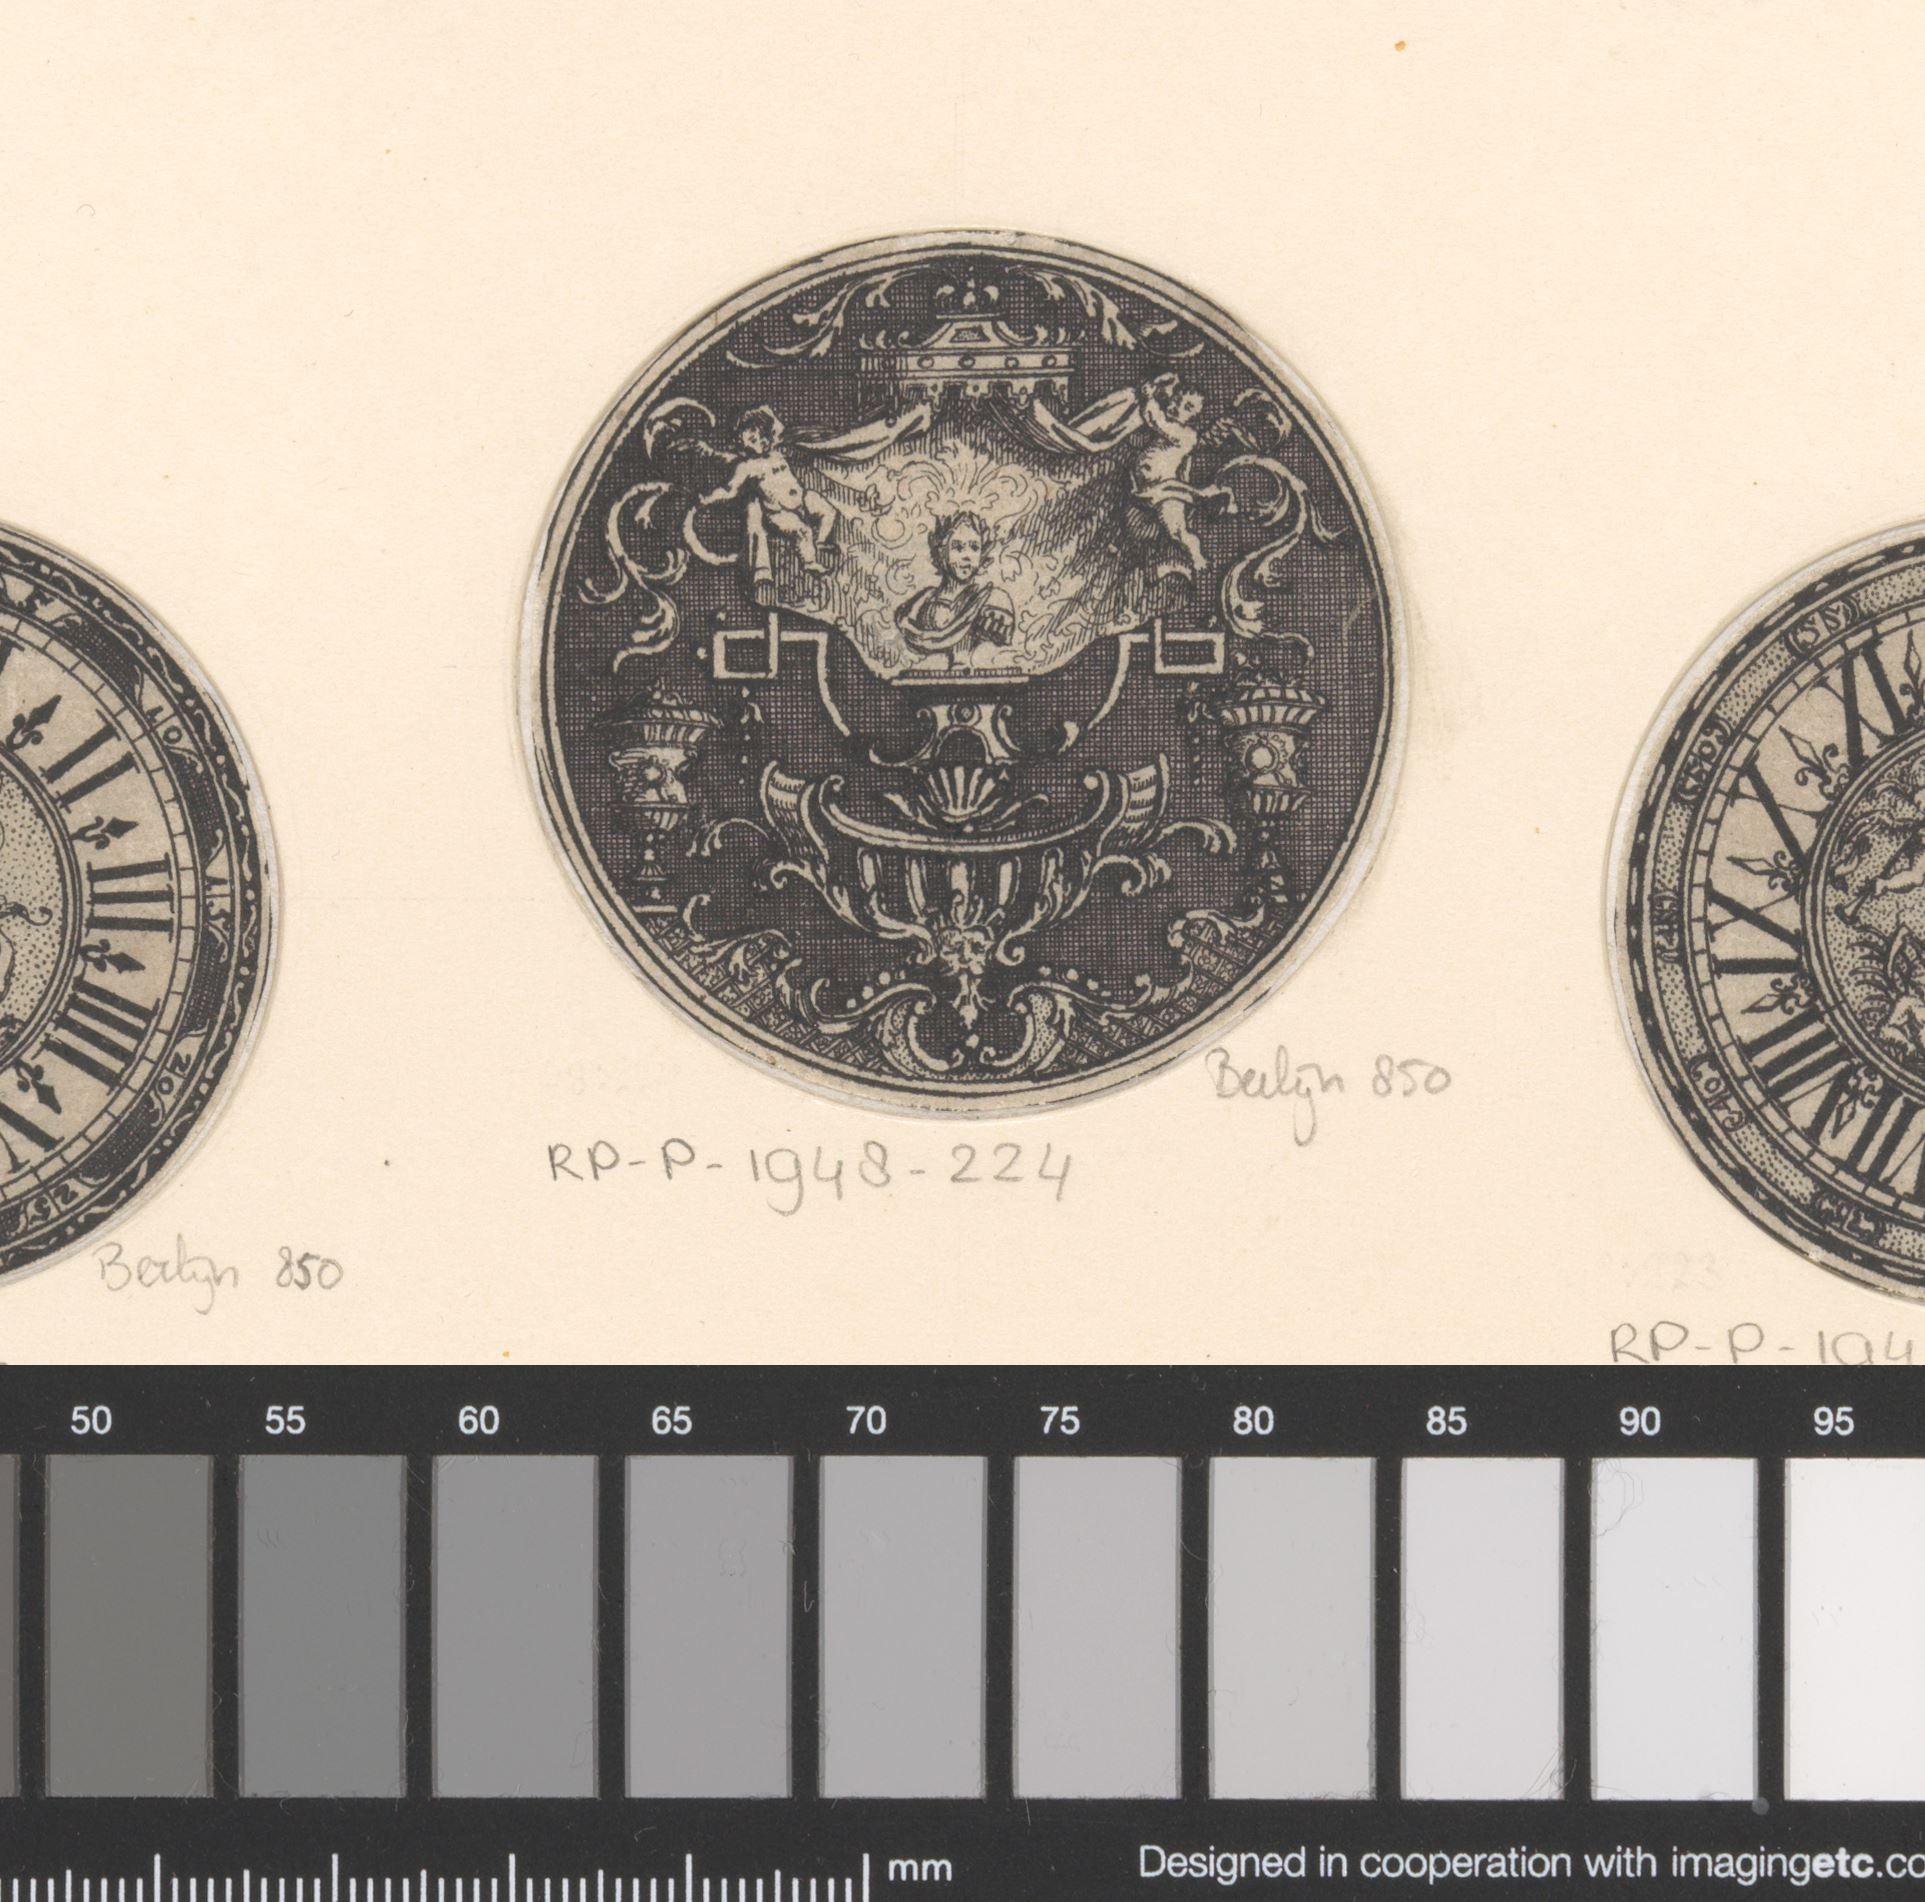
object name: print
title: Cirkelvulling met vazen, buste met putti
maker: Anonymous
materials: paper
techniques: etching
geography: paris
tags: chest, bust, vase ~ ornament, cupids: 'amores', 'amoretti', 'putti'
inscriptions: collector's mark: Lugt 1403b, collector's mark: Lugt 2228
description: Een mannelijke buste op een voetstuk staat voor een doek vastgehouden door twee putti. Links en rechts staan vazen. Rondom gedecoreerd met vlechtwerk.